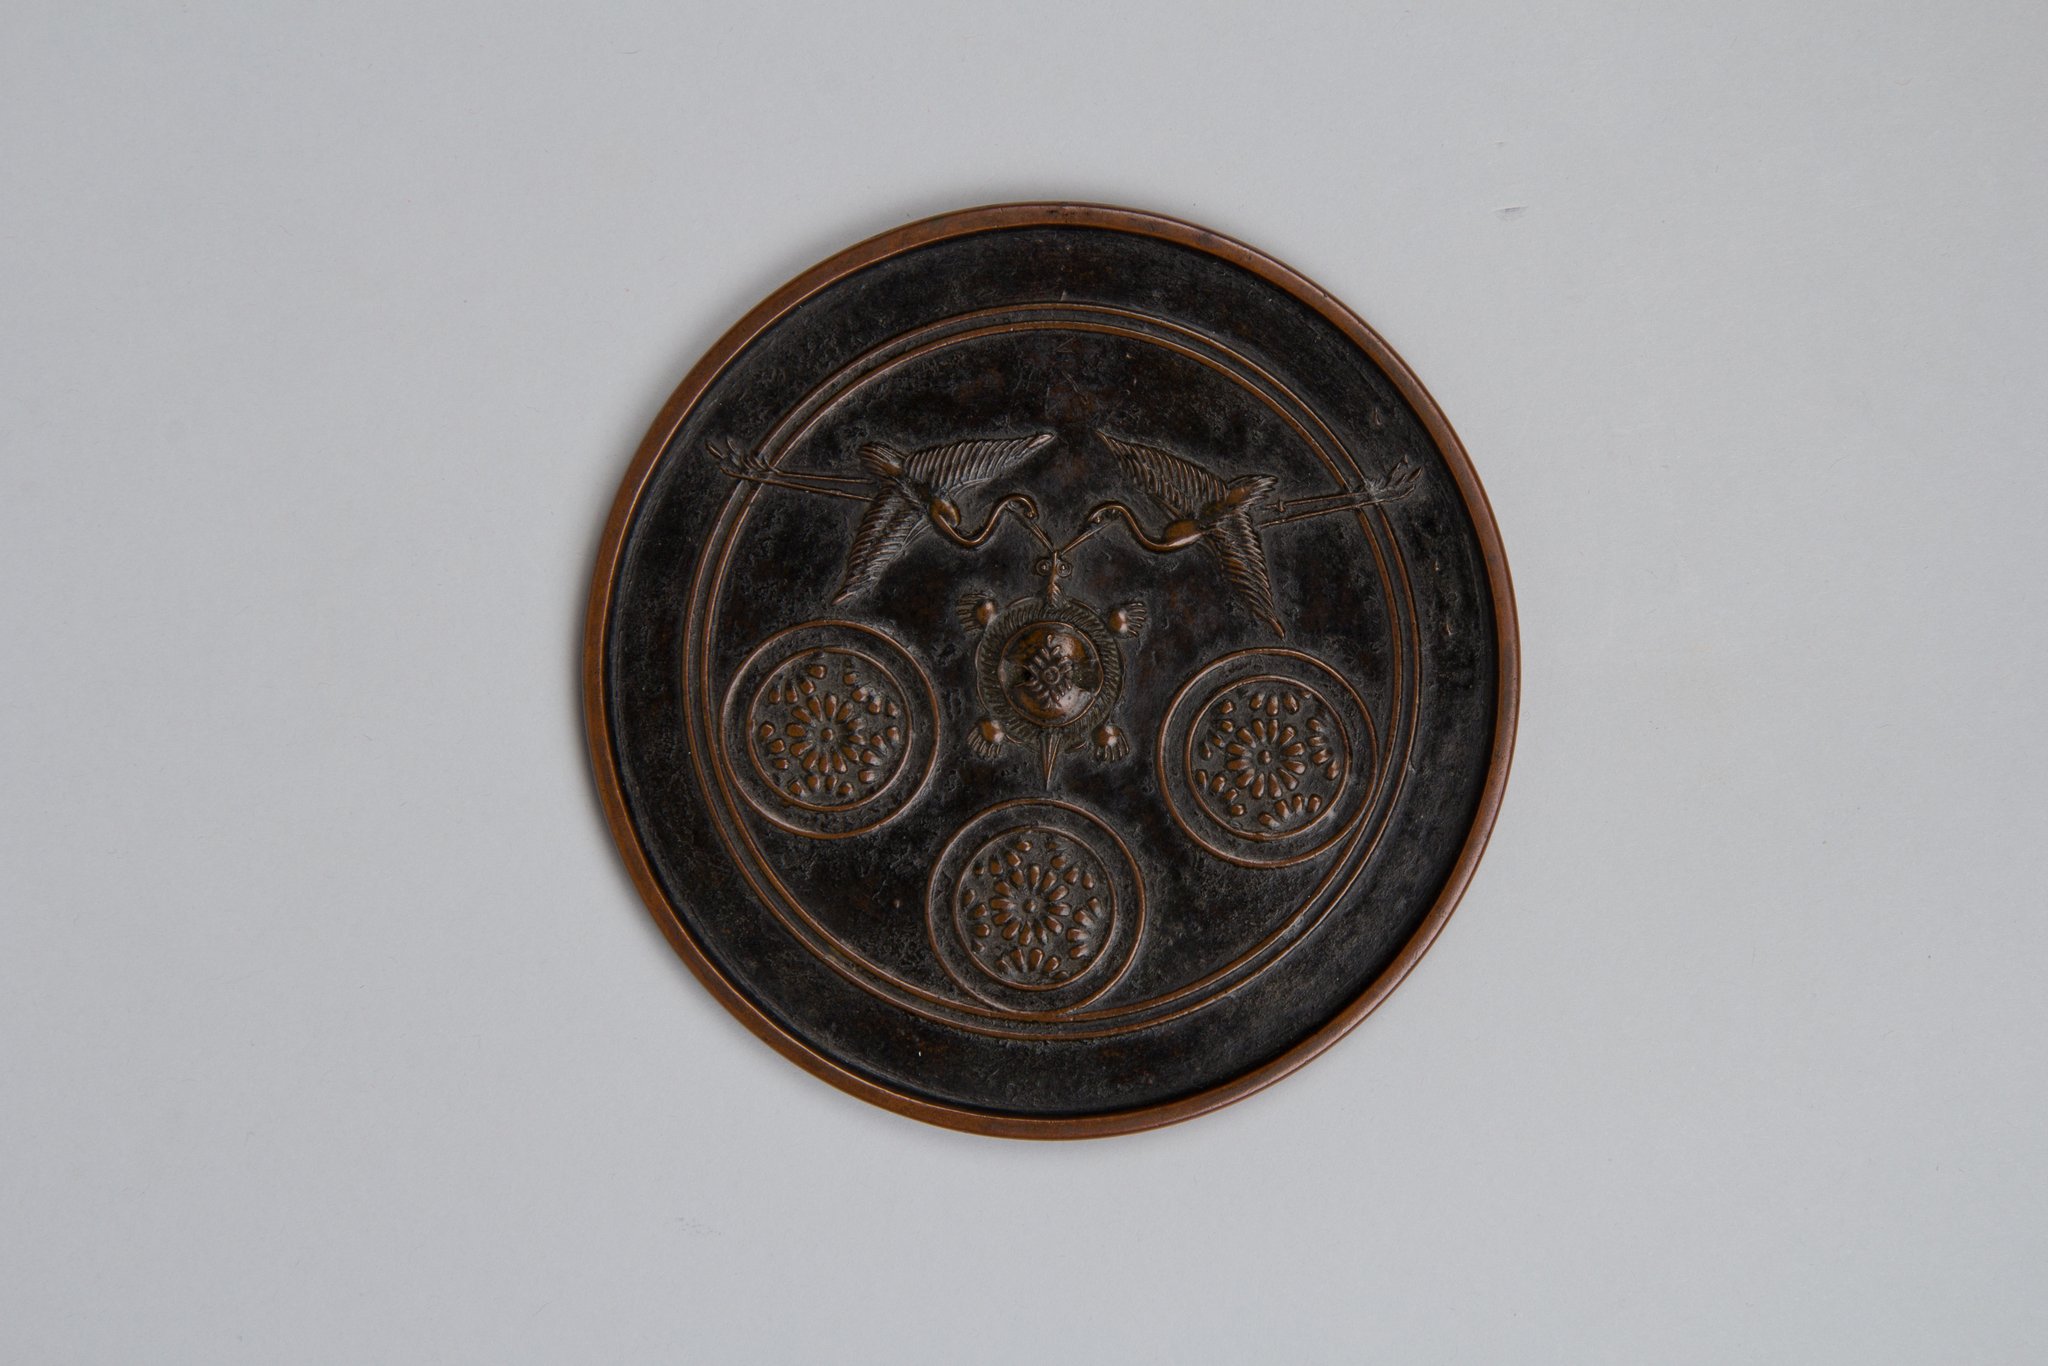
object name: mirror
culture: japanese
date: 1336-1573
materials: bronze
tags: cranes